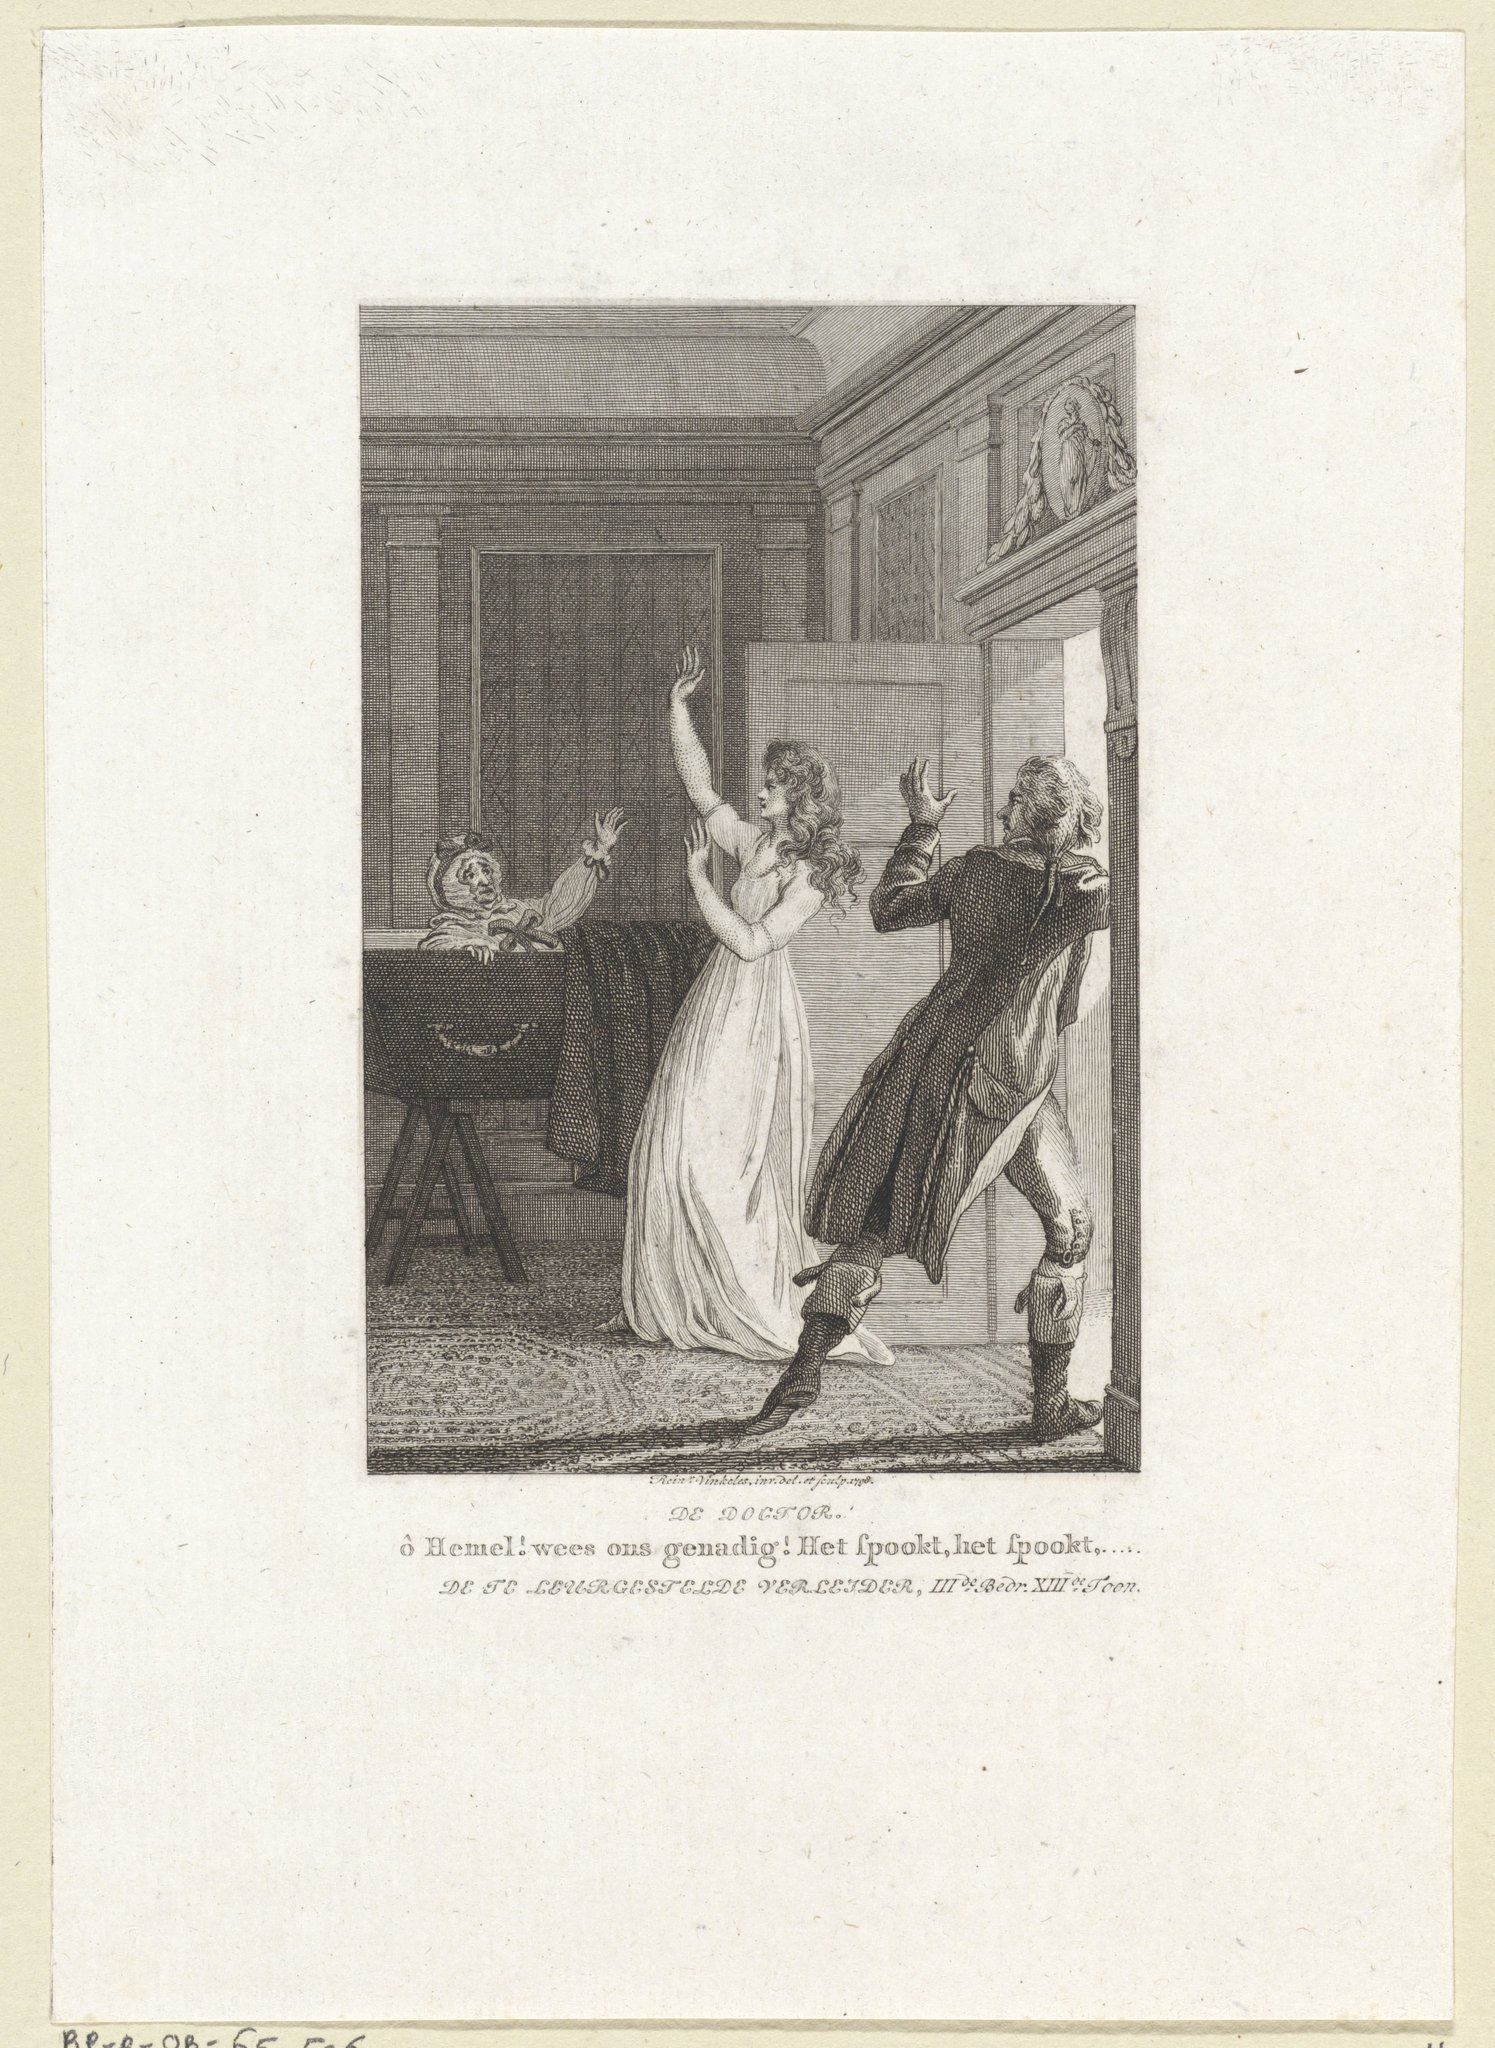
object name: print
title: Dood gewaande baby laat een vrouw en een man schrikken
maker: reinier vinkeles (i)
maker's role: draughtsman, print maker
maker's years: 1741-1816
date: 1798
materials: paper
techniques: engraving, etching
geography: amsterdam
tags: apparent death, infant, baby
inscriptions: collector's mark: Lugt 240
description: Deze prent is mogelijk ook gebruikt als illustratie in: De teleurgestelde verleider, of De schĳndoode. Amsterdam: erven van Pieter Meĳer en Gerrit Warnars, 1798.